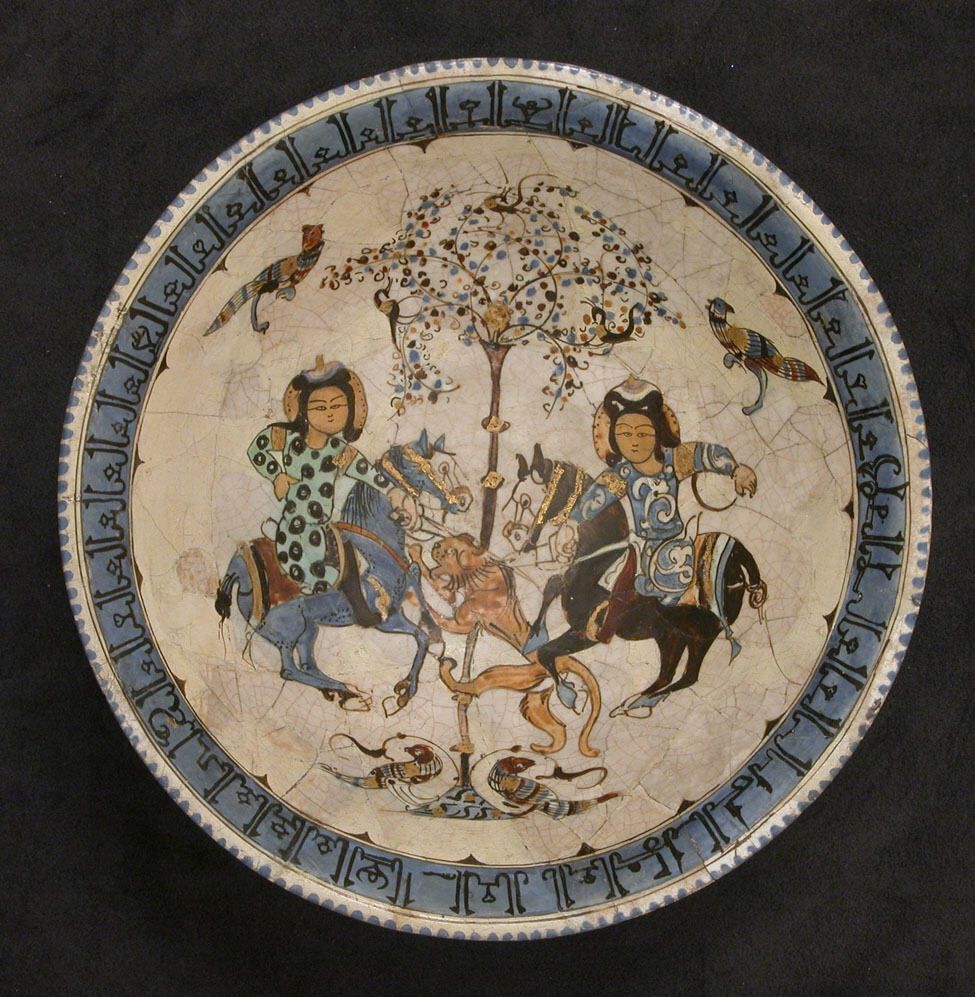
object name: bowl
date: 1101-1300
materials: stonepaste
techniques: overglaze, painting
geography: iran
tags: birds,men,horses,lions